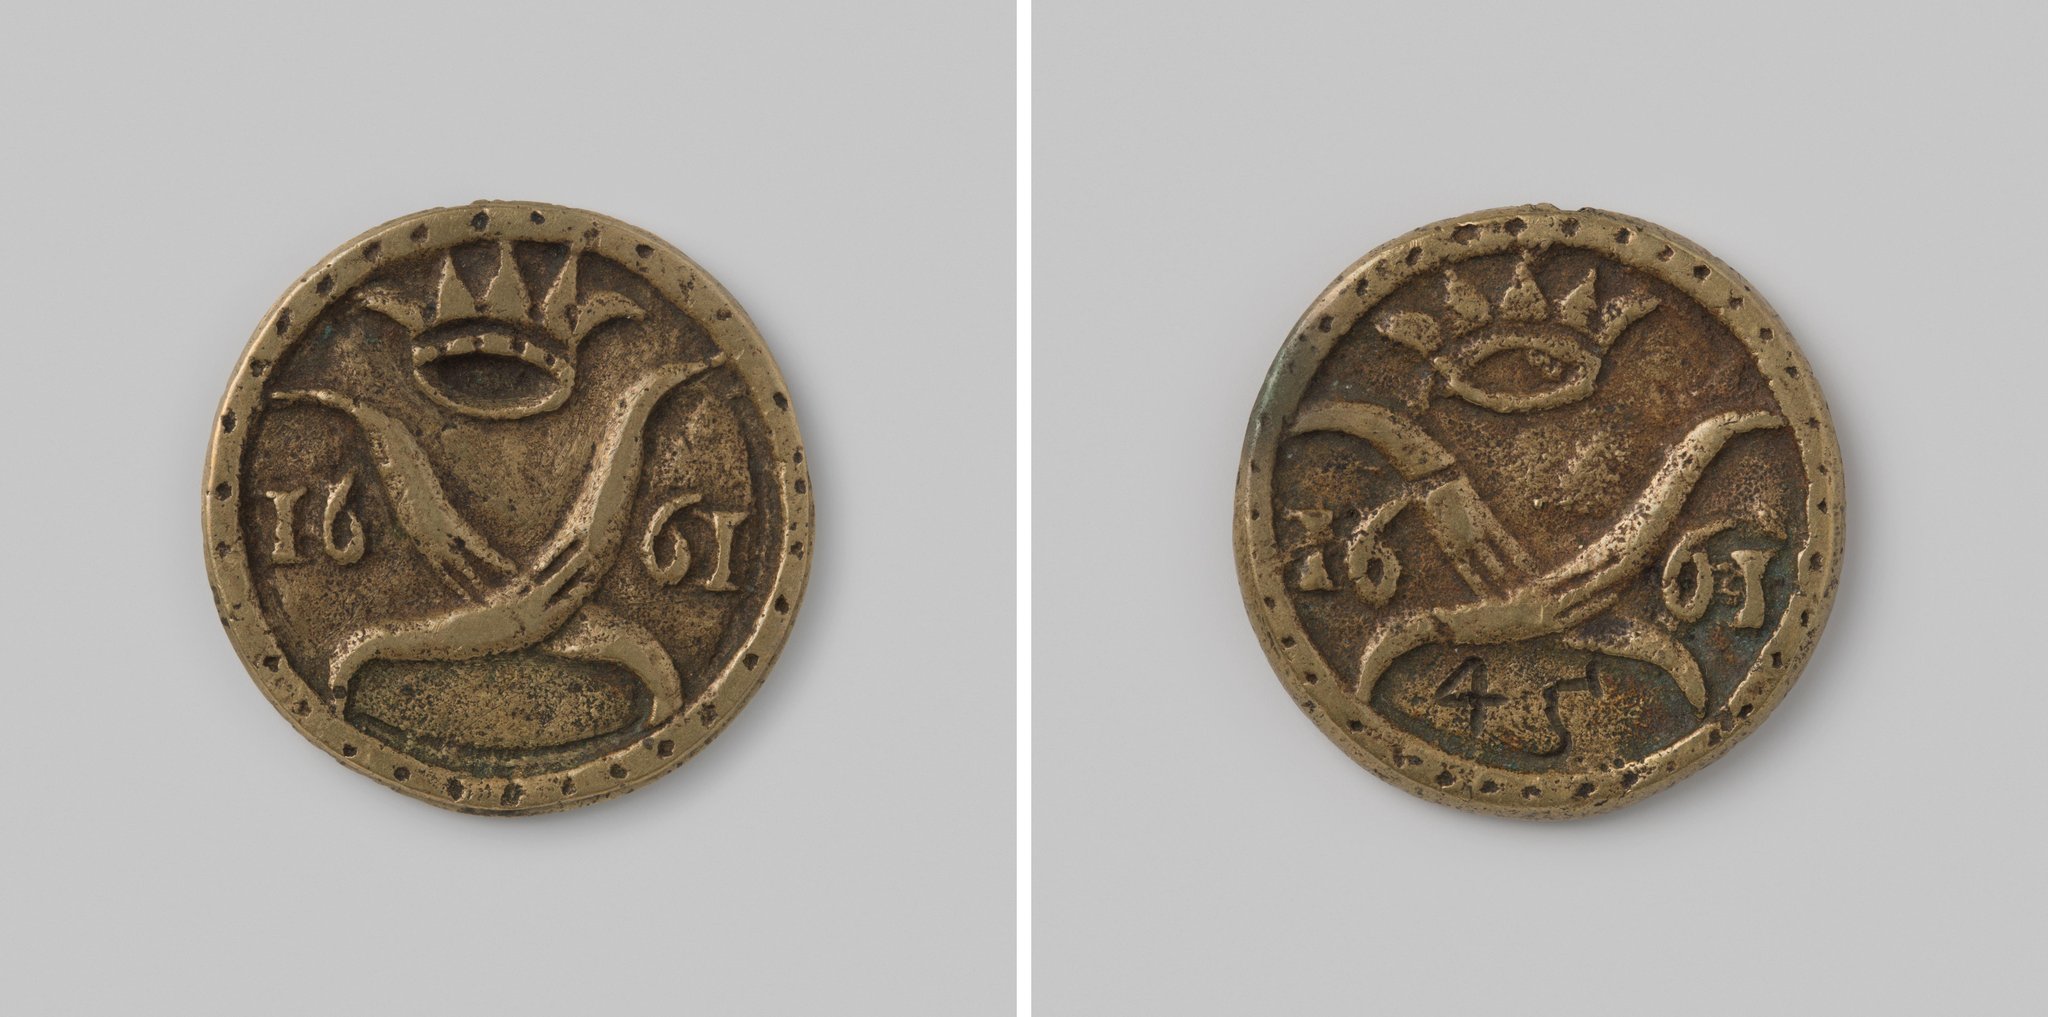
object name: medal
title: Presentiepenning van het Weversgilde te Aardenburg 1661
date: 1661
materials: brass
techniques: casting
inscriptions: inscription: ‘45’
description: Gegoten messing penning, beiderzijds twee weversspoelen onder een kroon en tussenl 16 en 61 binnen een versierde rand, op een zijde ingestempeld het getal 45, in de rand een gleuf met bovenaan een verdieping